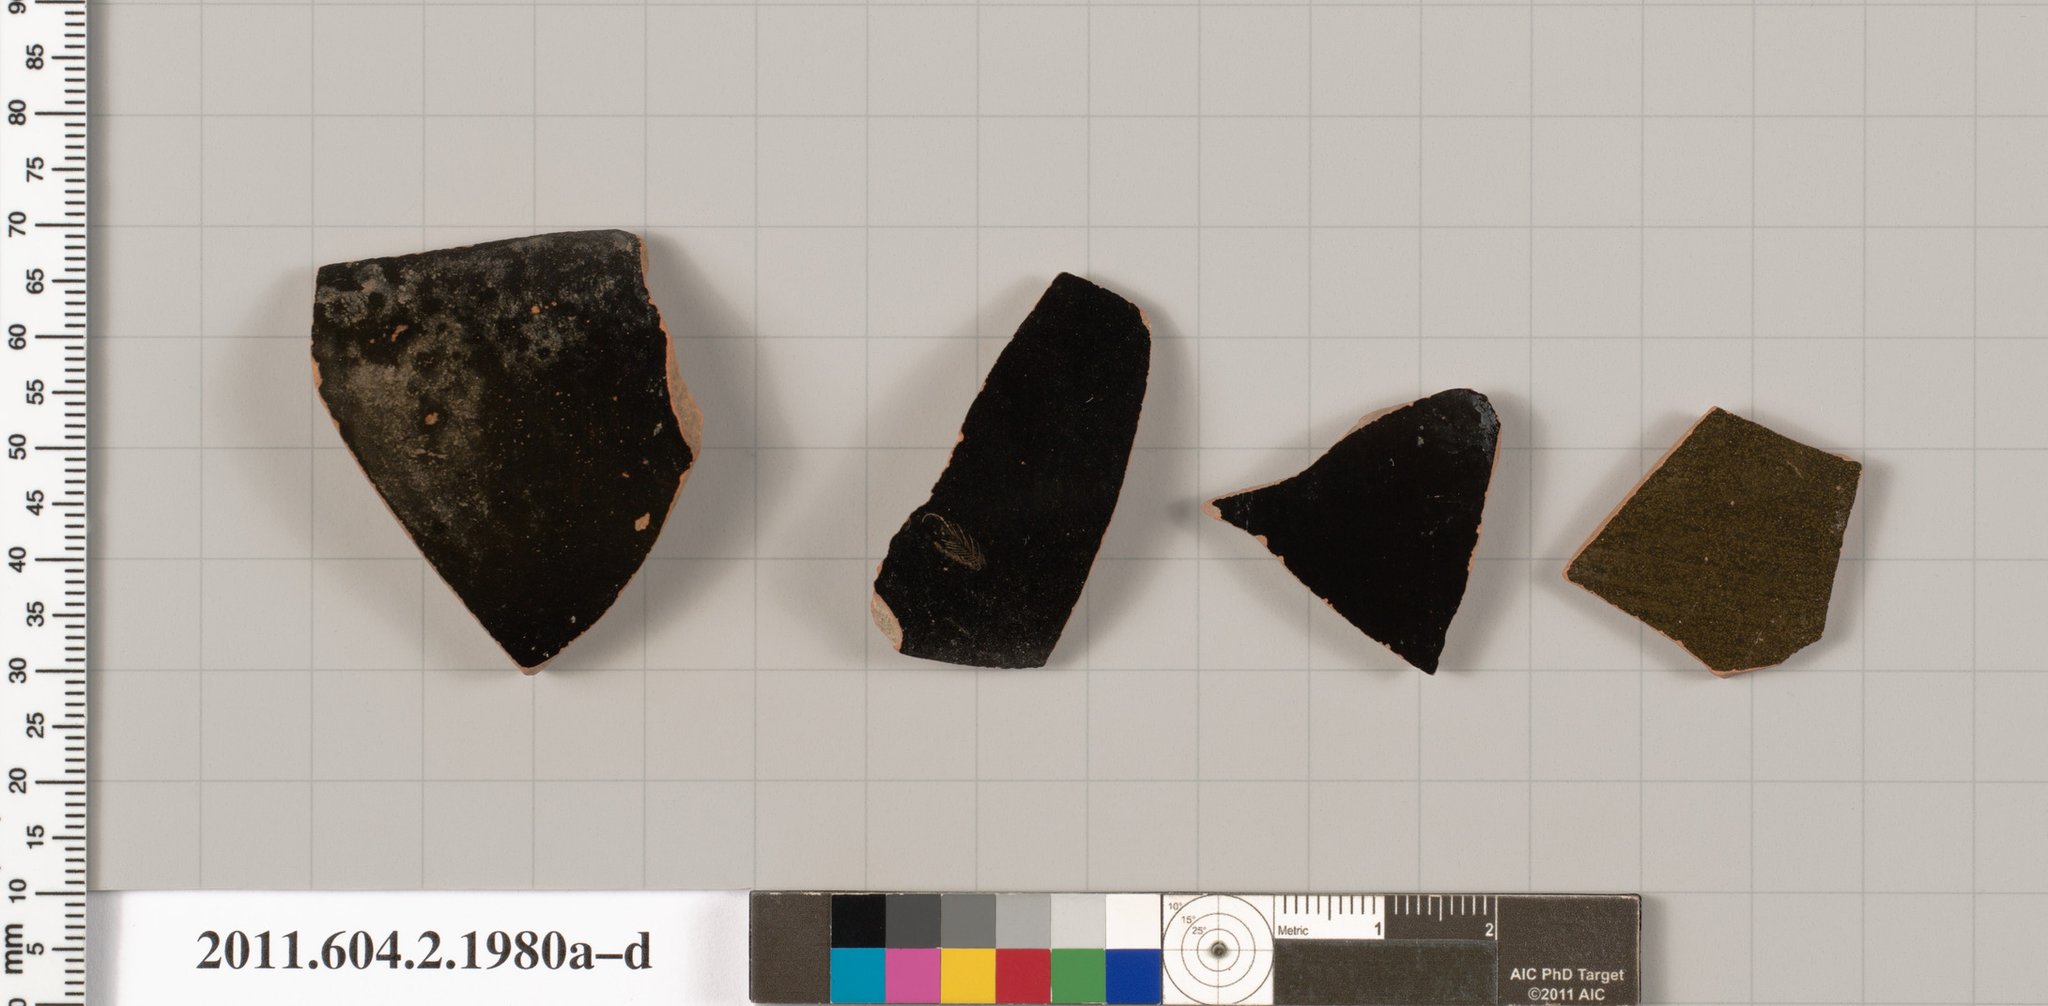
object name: pot fragment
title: Terracotta fragments of pots; unglazed on the inside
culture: greek, attic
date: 500-401 BCE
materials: terracotta